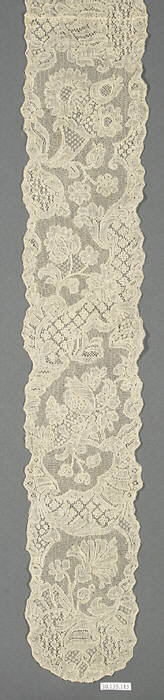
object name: lappet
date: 1701-1800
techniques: lace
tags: flowers